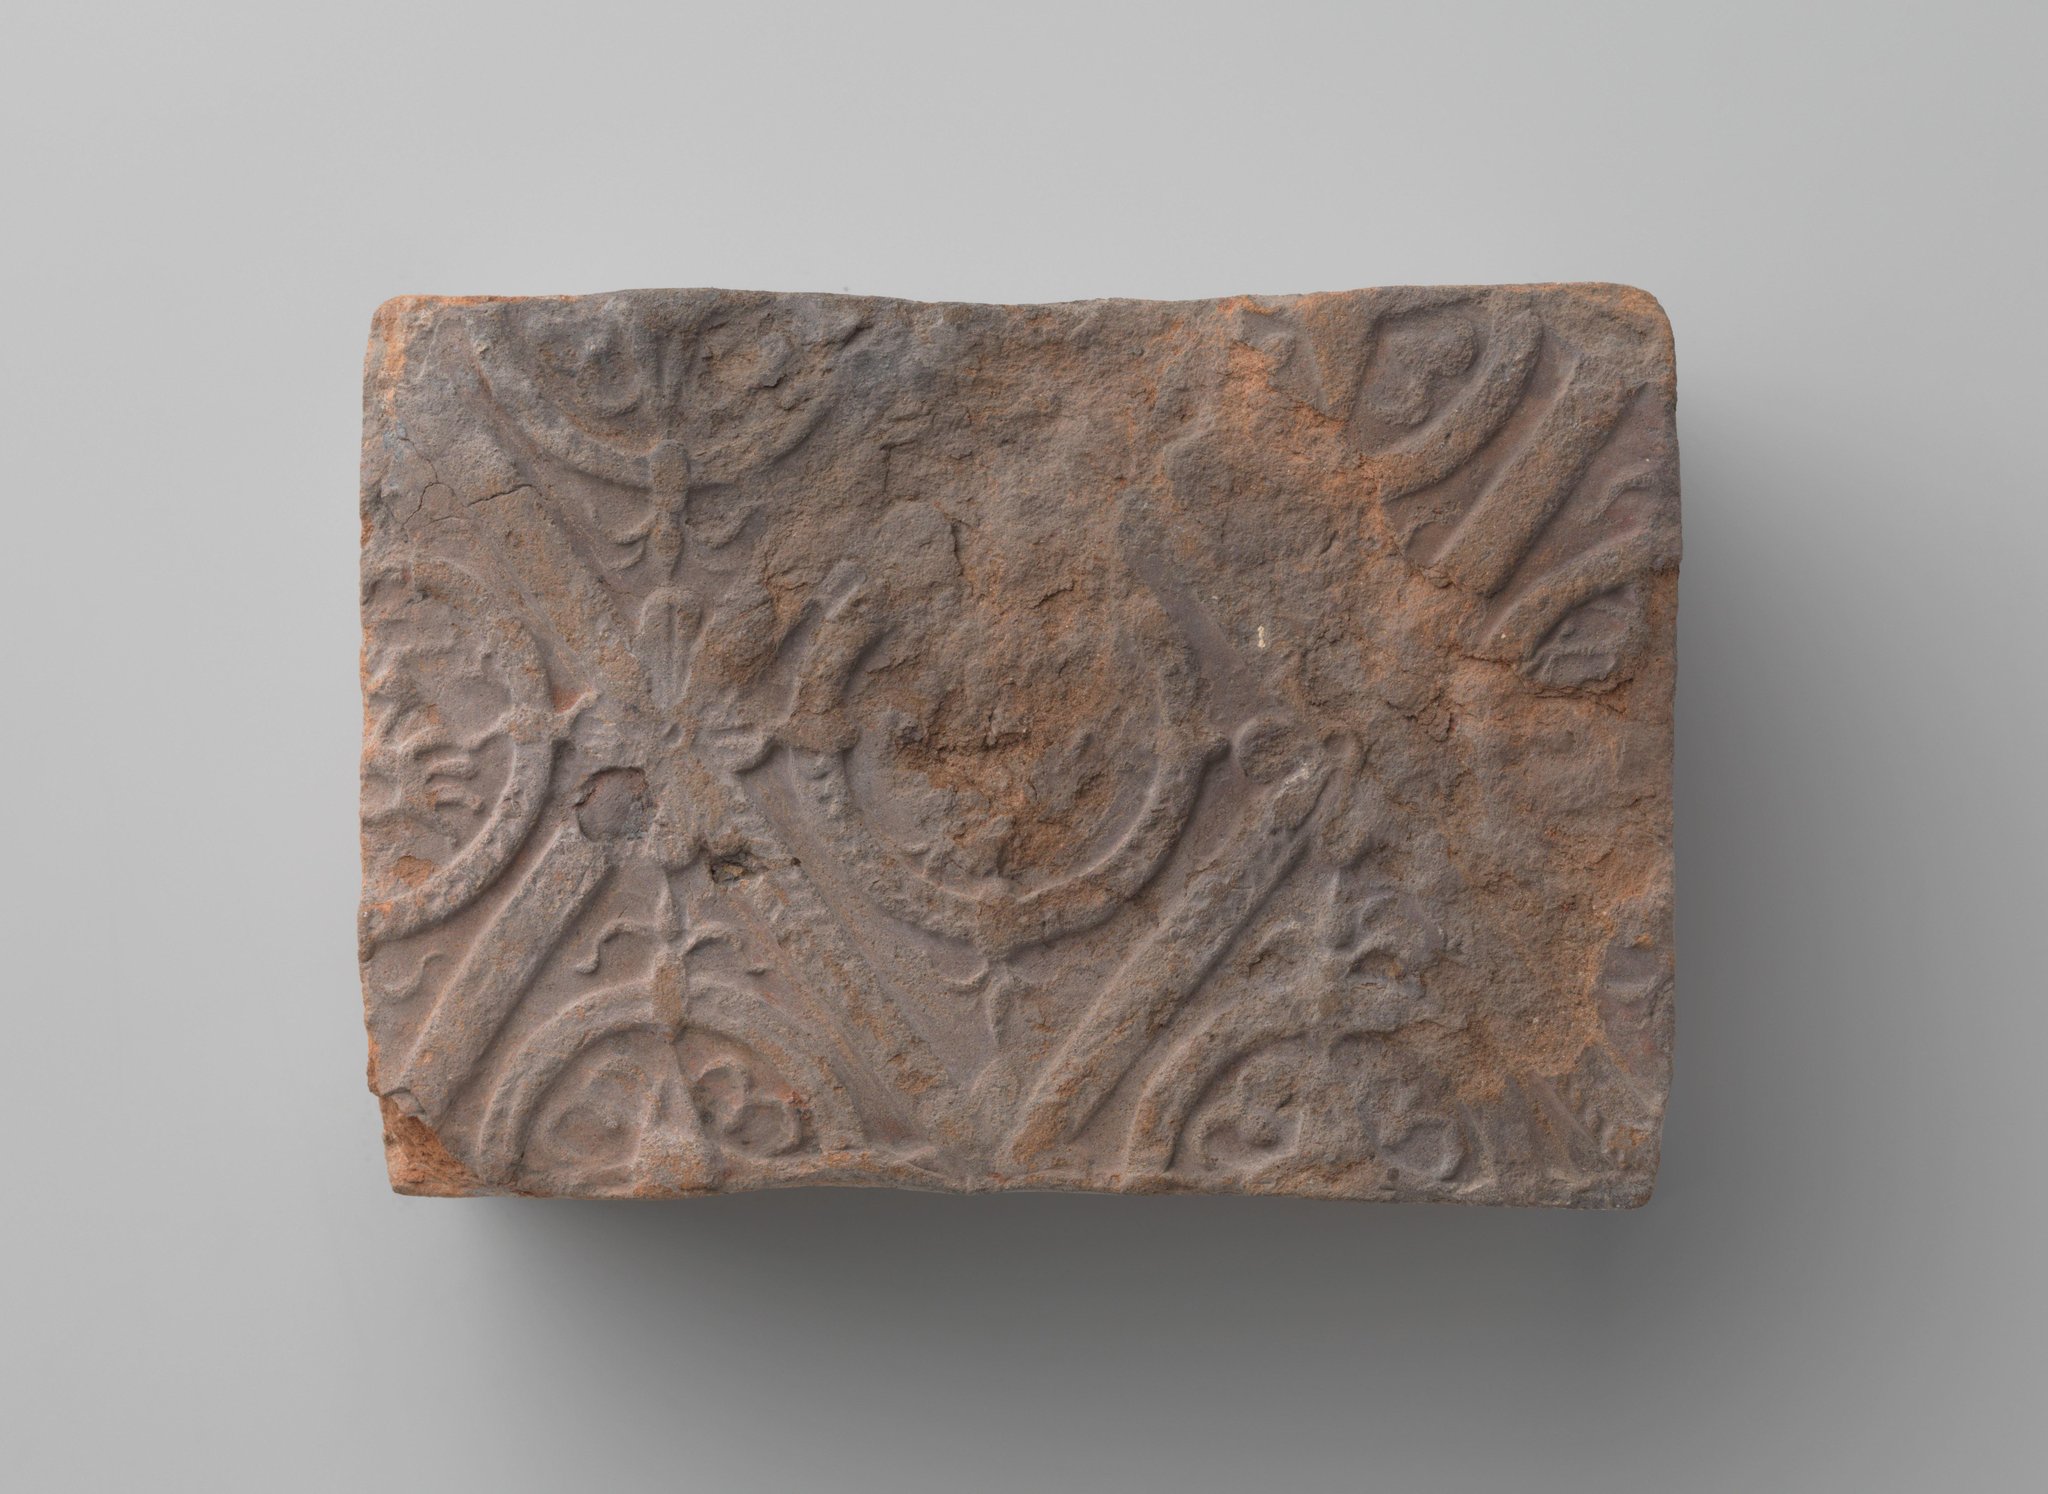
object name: hearthstone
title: Haardsteen met mannenkop en de letters V I in lauwerkrans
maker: Anonymous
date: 1575-1625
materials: earthenware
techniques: printing, firing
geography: southern netherlands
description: Haardsteen met voorstelling van mannenkop en de letters V I in lauwerkrans, geplaatst in geprofileerde ruit. In de halve ruiten aan de zijkanten een dubbelkoppige adelaar. De halve ruiten aan de boven- en onderkant zijn opgevuld met halve medaillons met stermotief.